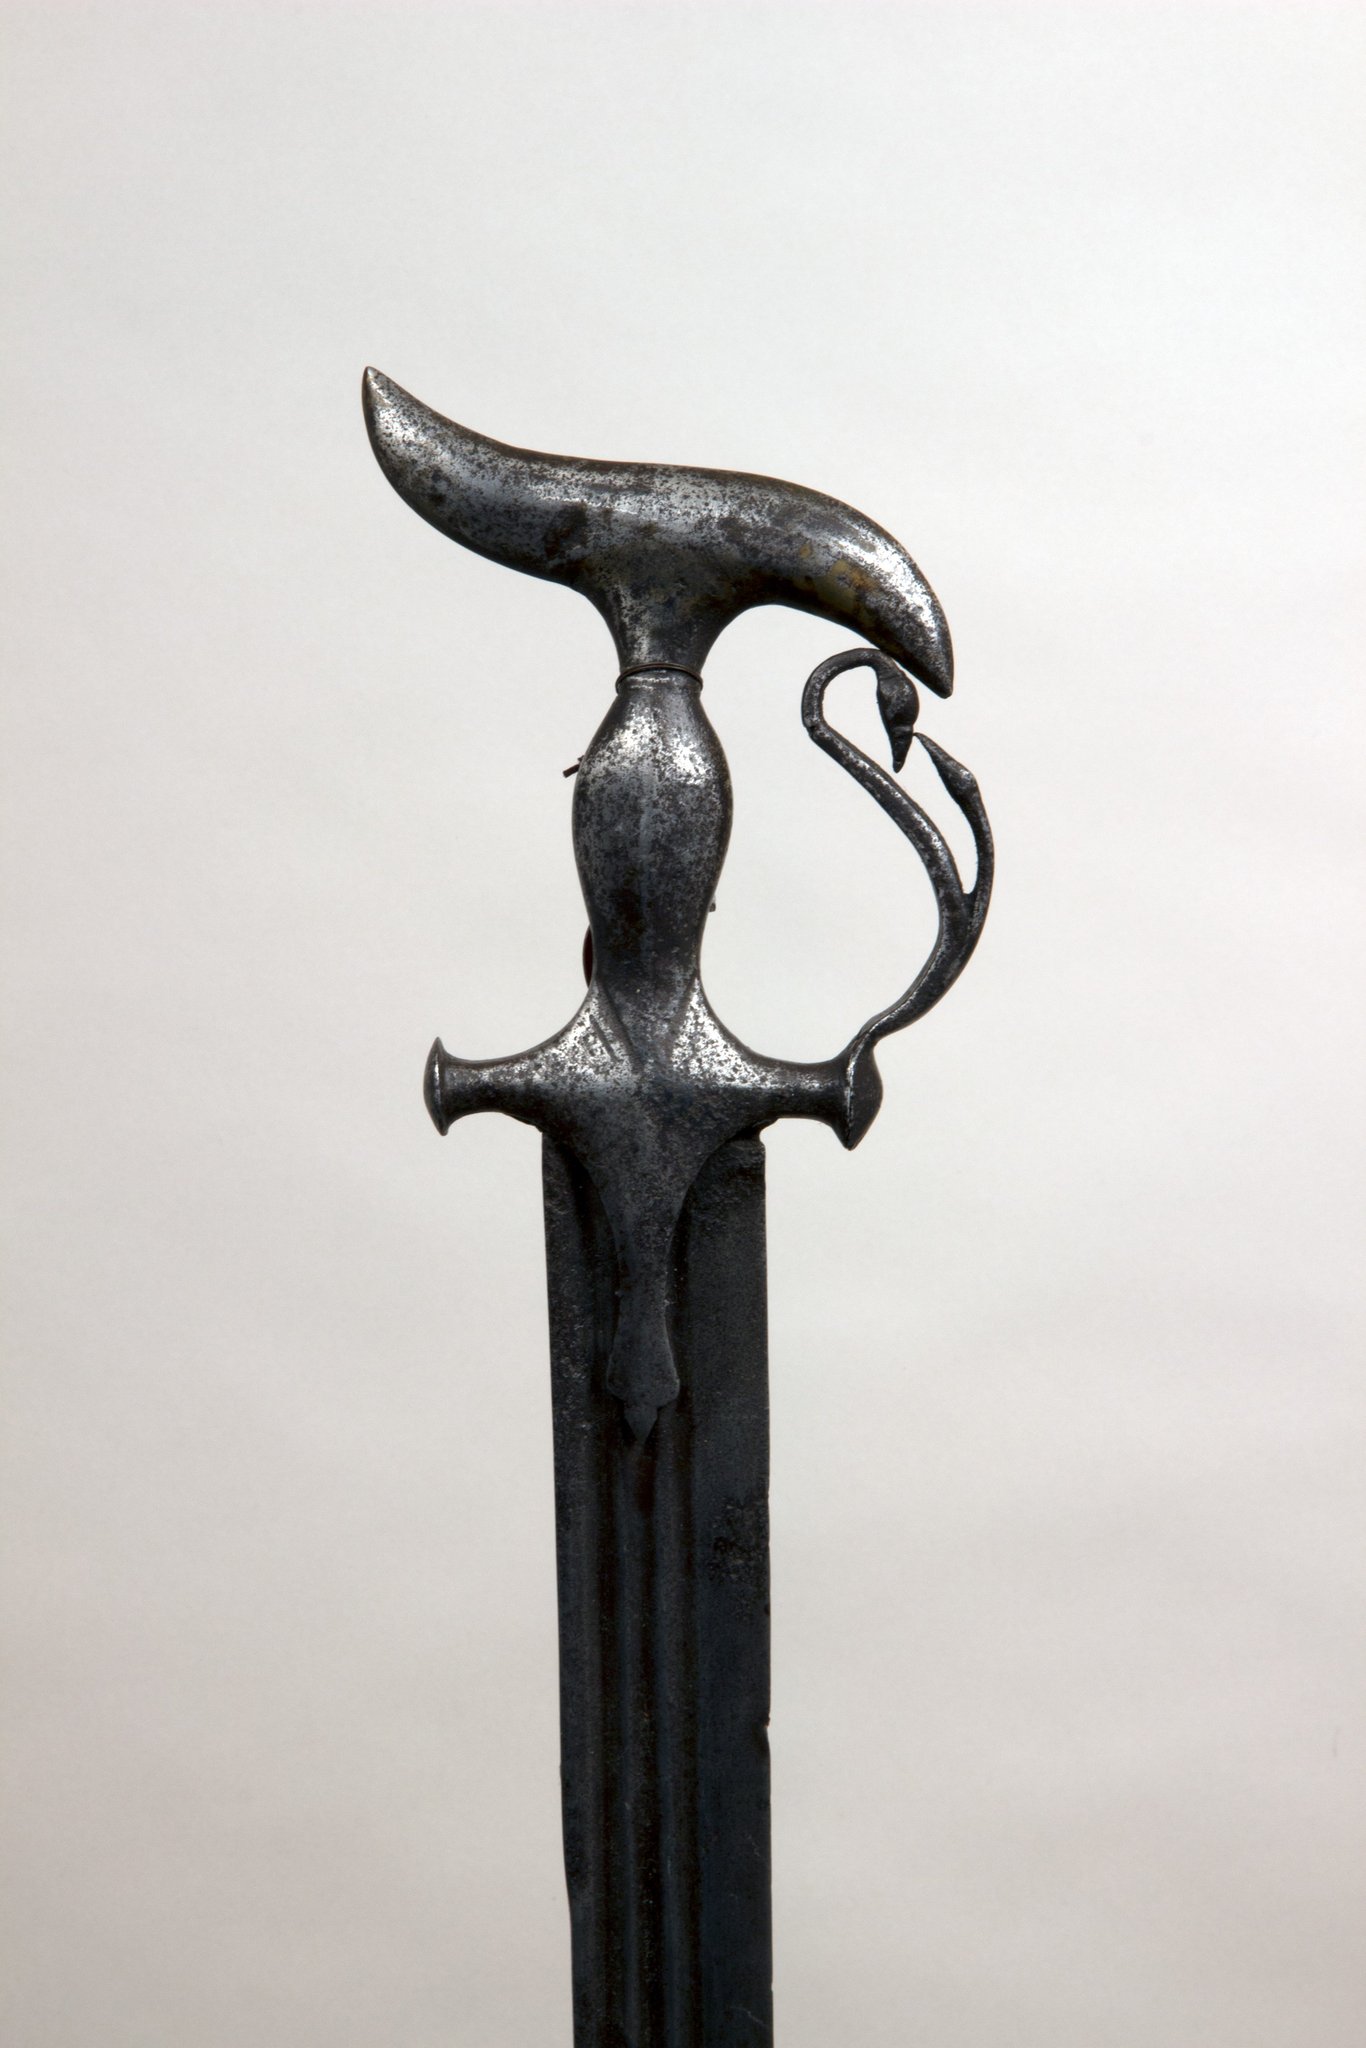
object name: sword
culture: indian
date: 1701-1900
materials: steel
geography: india